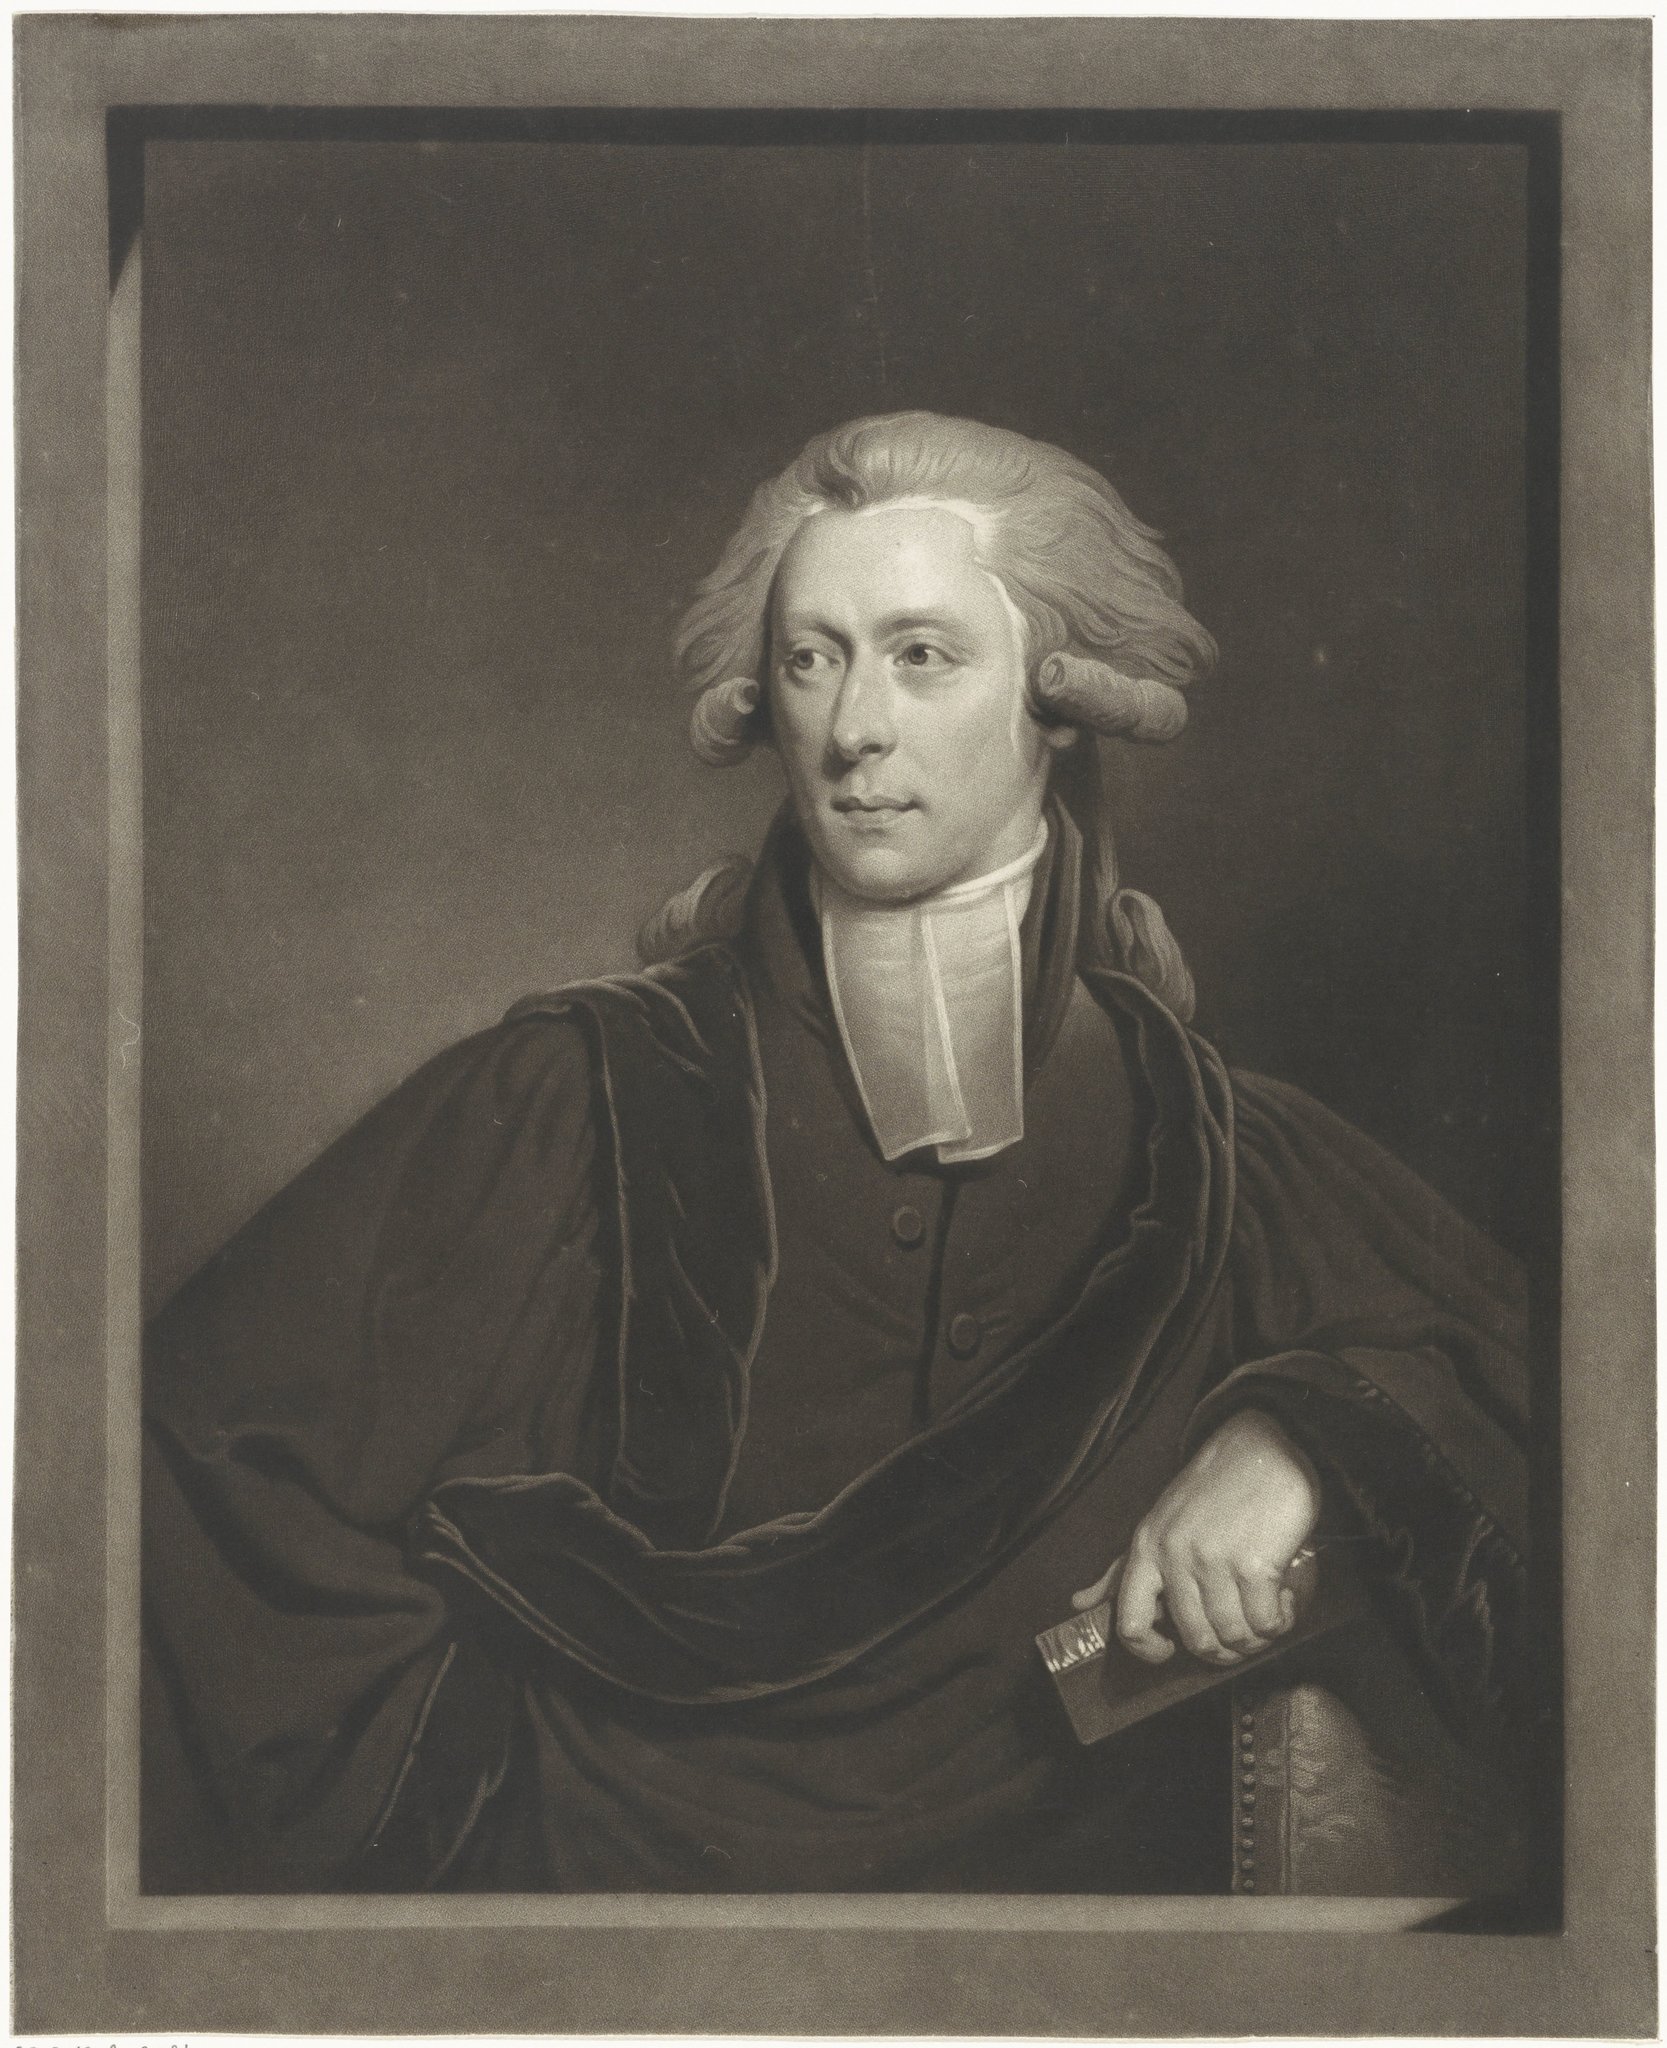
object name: print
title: Portret van Sebald Fulco Johannes Rau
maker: charles howard hodges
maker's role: draughtsman, painter, print maker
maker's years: 1764-1837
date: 1801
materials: paper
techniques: mezzotint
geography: amsterdam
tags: utrecht, leiden, book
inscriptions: collector's mark: Lugt 2228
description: Sebald Fulco Johannes Rau, hoogleraar theologie en oosterse talen te Leiden, met in de hand een boek.